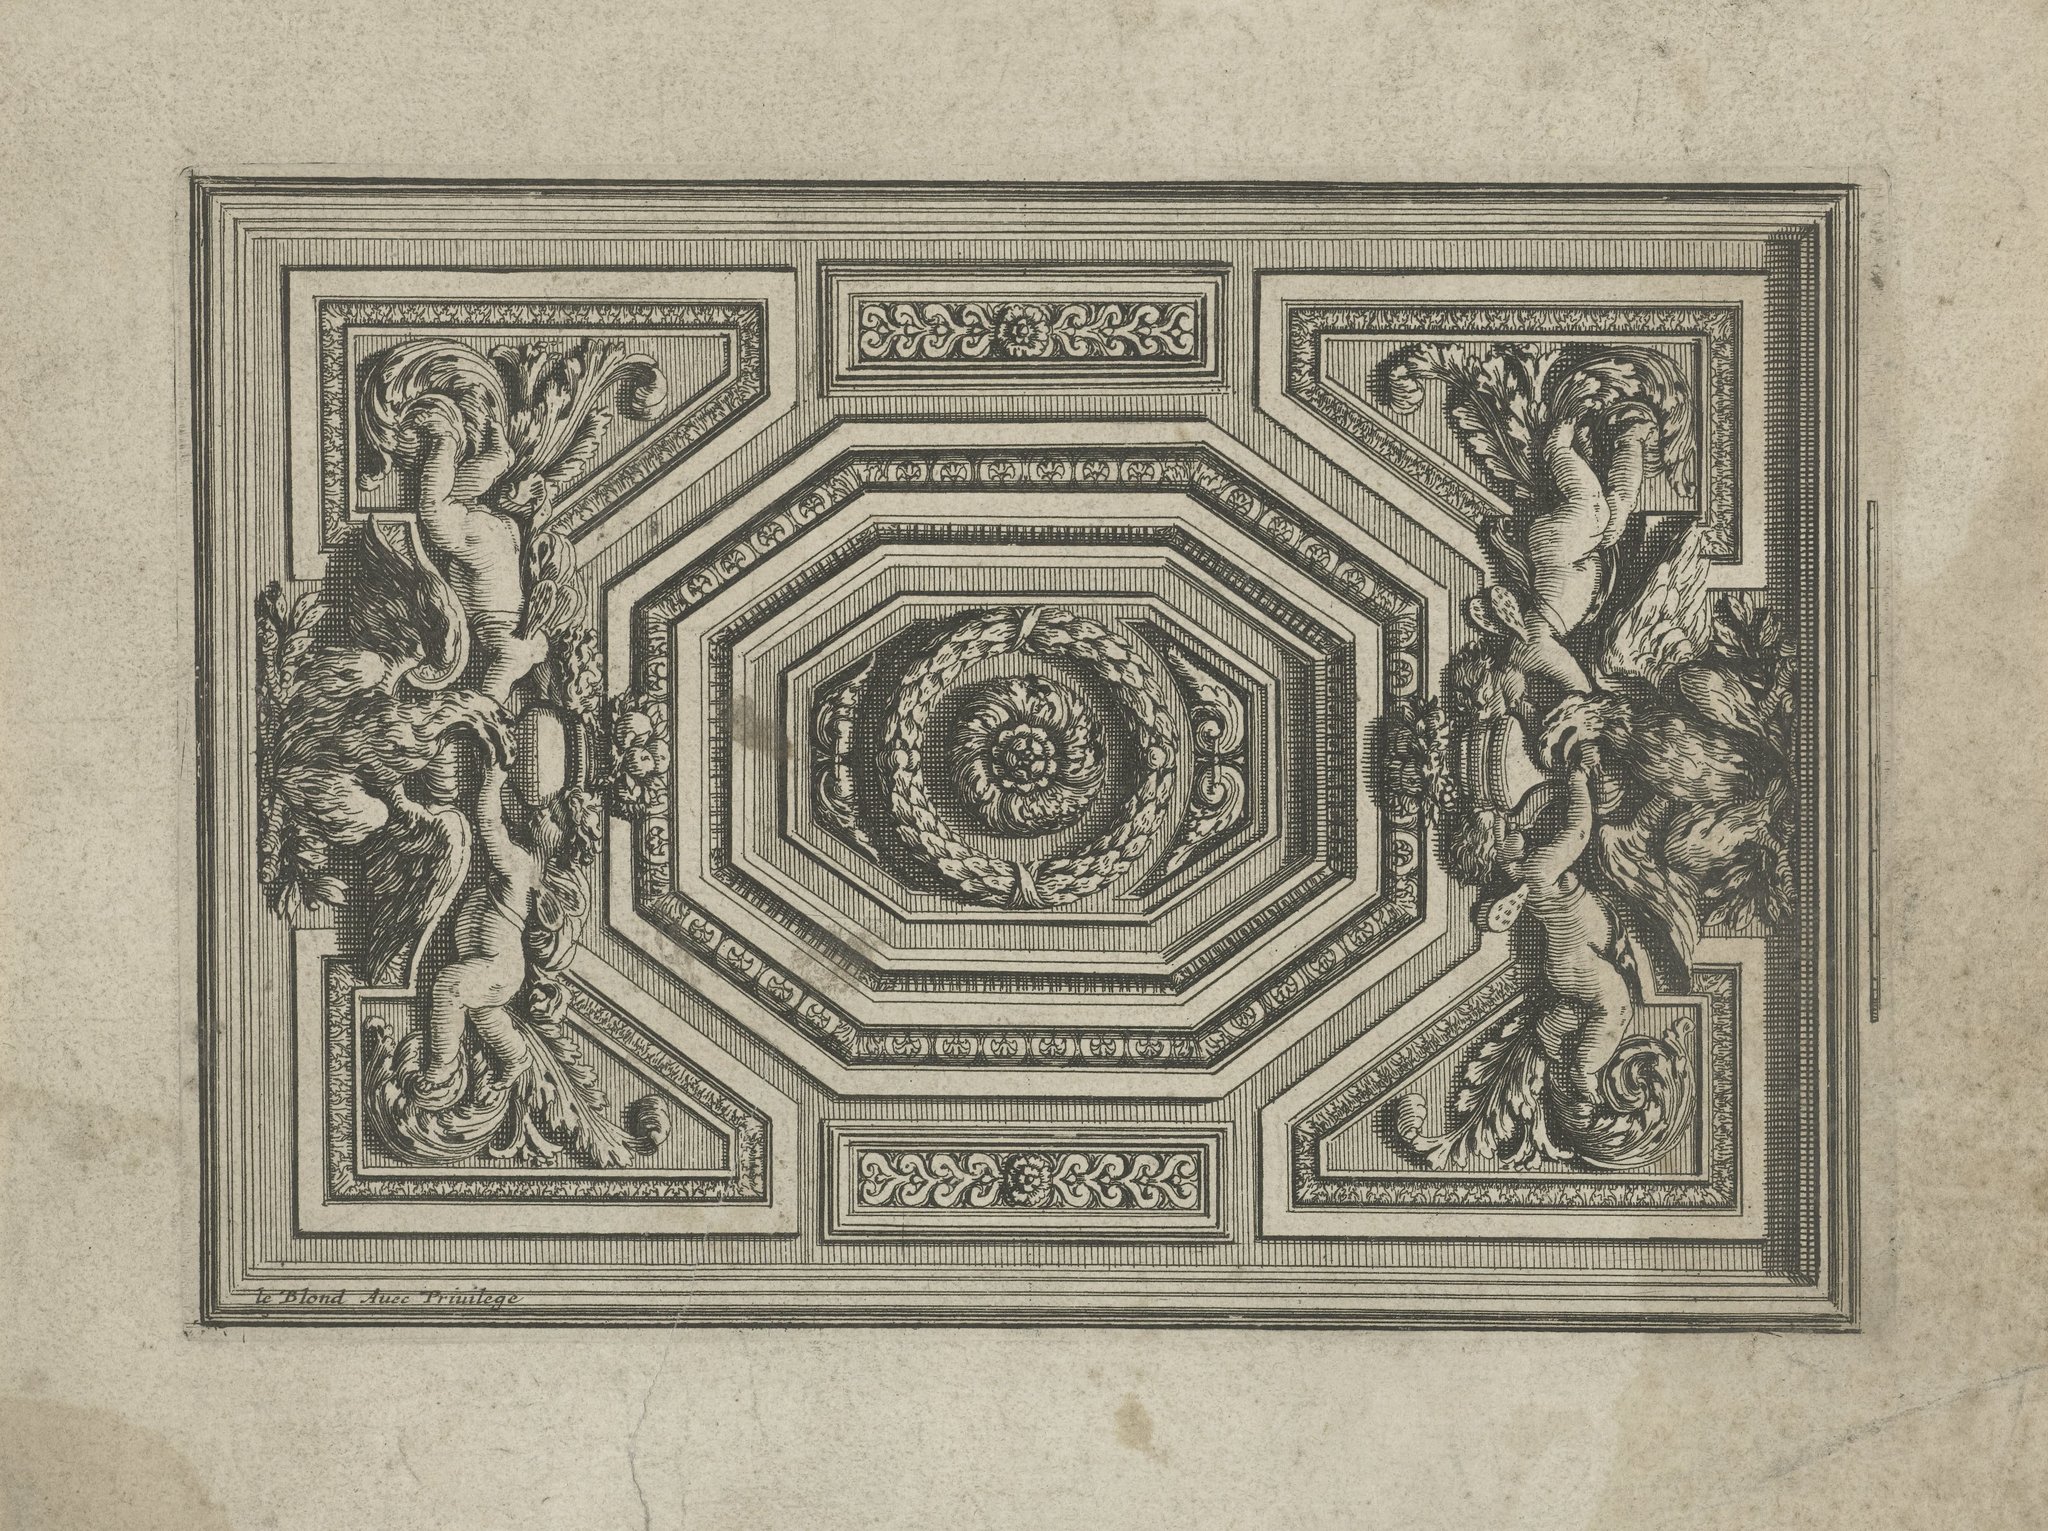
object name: ornament print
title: Plafond met achthoekig paneel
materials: paper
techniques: etching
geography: paris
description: Aan weerskanten van het paneel zit een adelaar tussen twee cherubijnen die een vaas met fruit vasthouden. Blad 7 uit serie van 12.